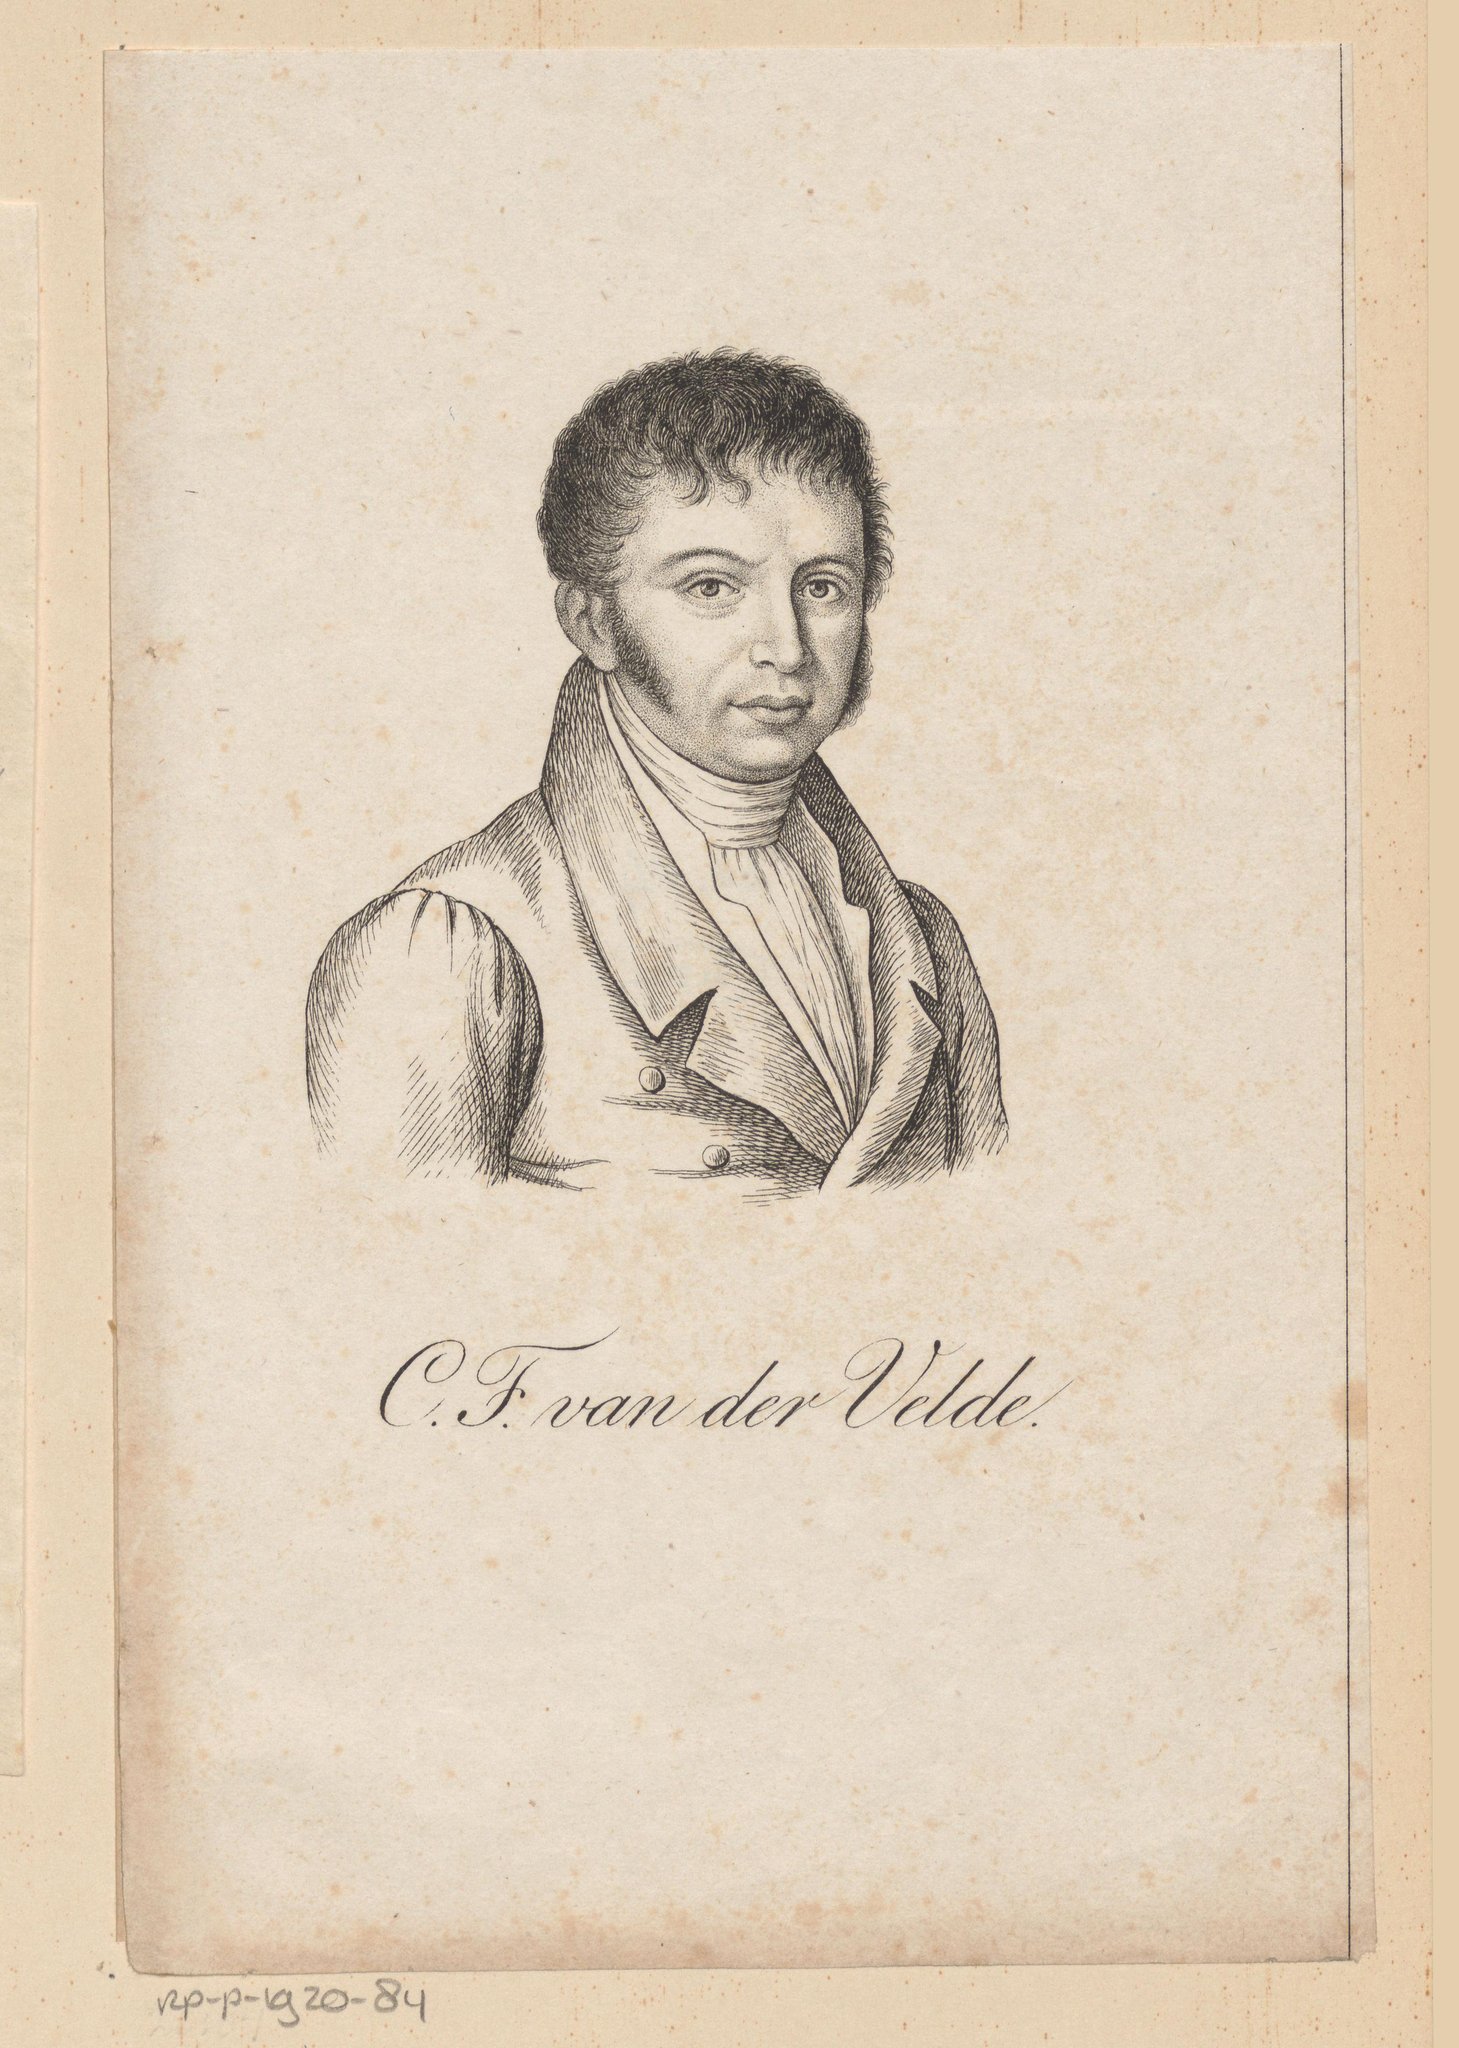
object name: print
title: Portret van Carl Franz van der Velde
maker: Anonymous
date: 1824-1870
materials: paper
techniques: engraving, etching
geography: germany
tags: historical persons, lawyer, attorney at law, portrait of a writer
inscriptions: collector's mark: Lugt 2228